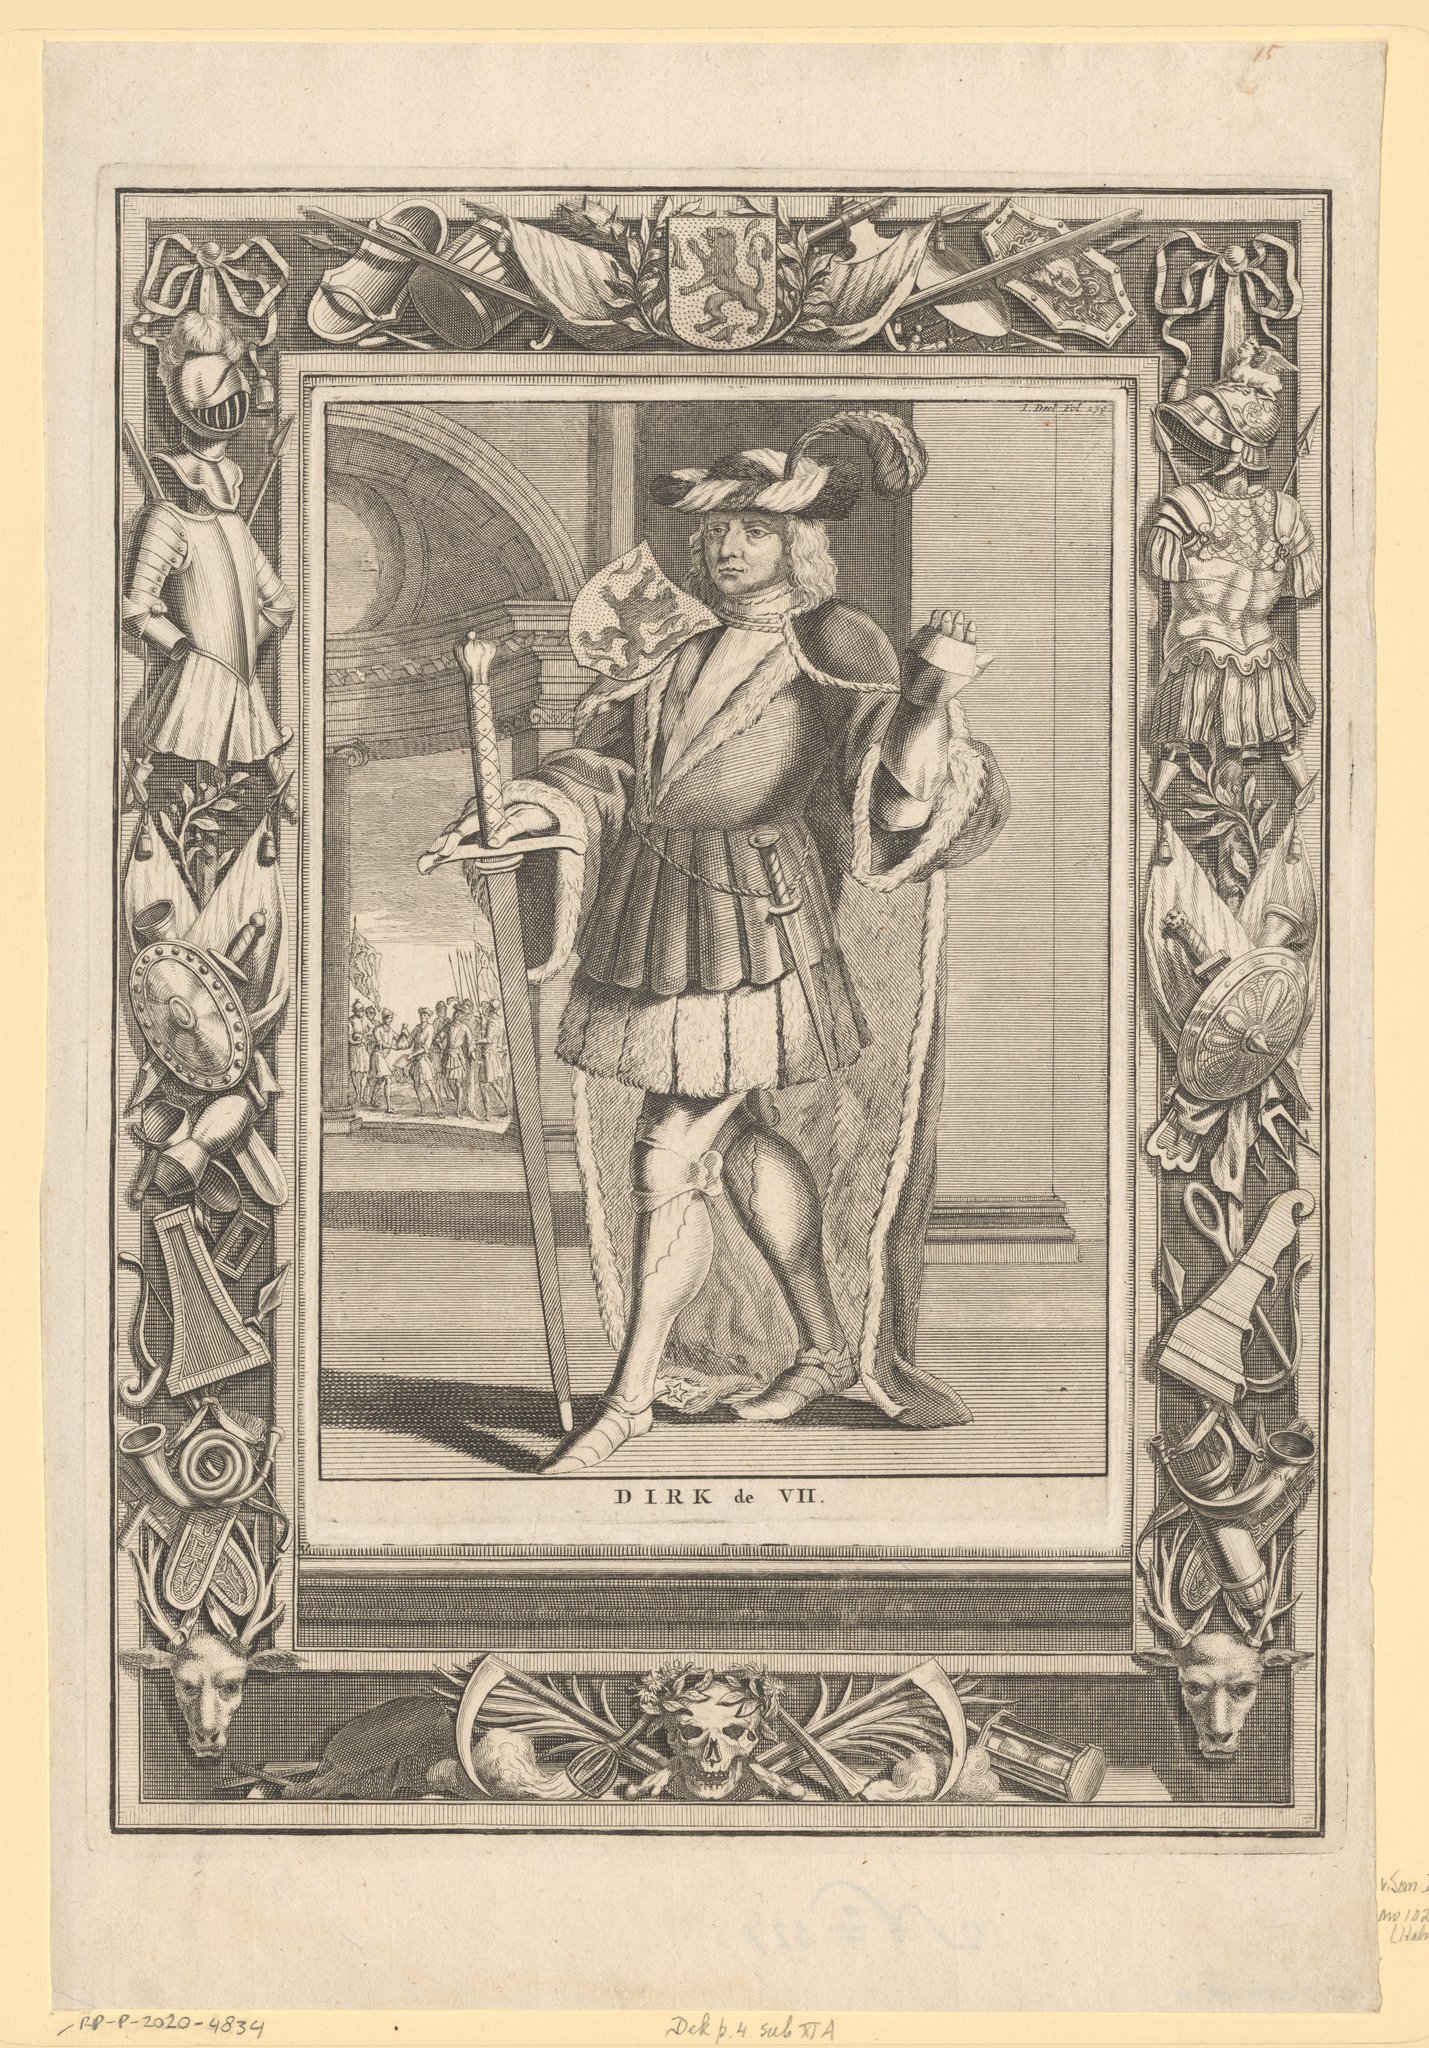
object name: print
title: Portret van Dirk VII, graaf van Holland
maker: Anonymous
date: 1725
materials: paper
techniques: engraving, etching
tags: historical persons, hacking and thrusting weapons: sword, ruler, sovereign, armorial bearing, heraldry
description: Prent mogelijk uit: Halma, François. Tooneel der Vereenigde Nederlanden, en onderhorige landschappen (...). 2 dln. Leeuwarden: Hendrik Halma, 1725, dl. 1, fol. 239. Eerdere staat van prent gebruikt in: Stoke, Melis. Hollandse jaar-boeken of rijm-kronijk van Melis Stoke. Behelsende de geschiedenissen des lands (...). Leiden: Johannes du Vivié en Isaak Severinus, 1699.